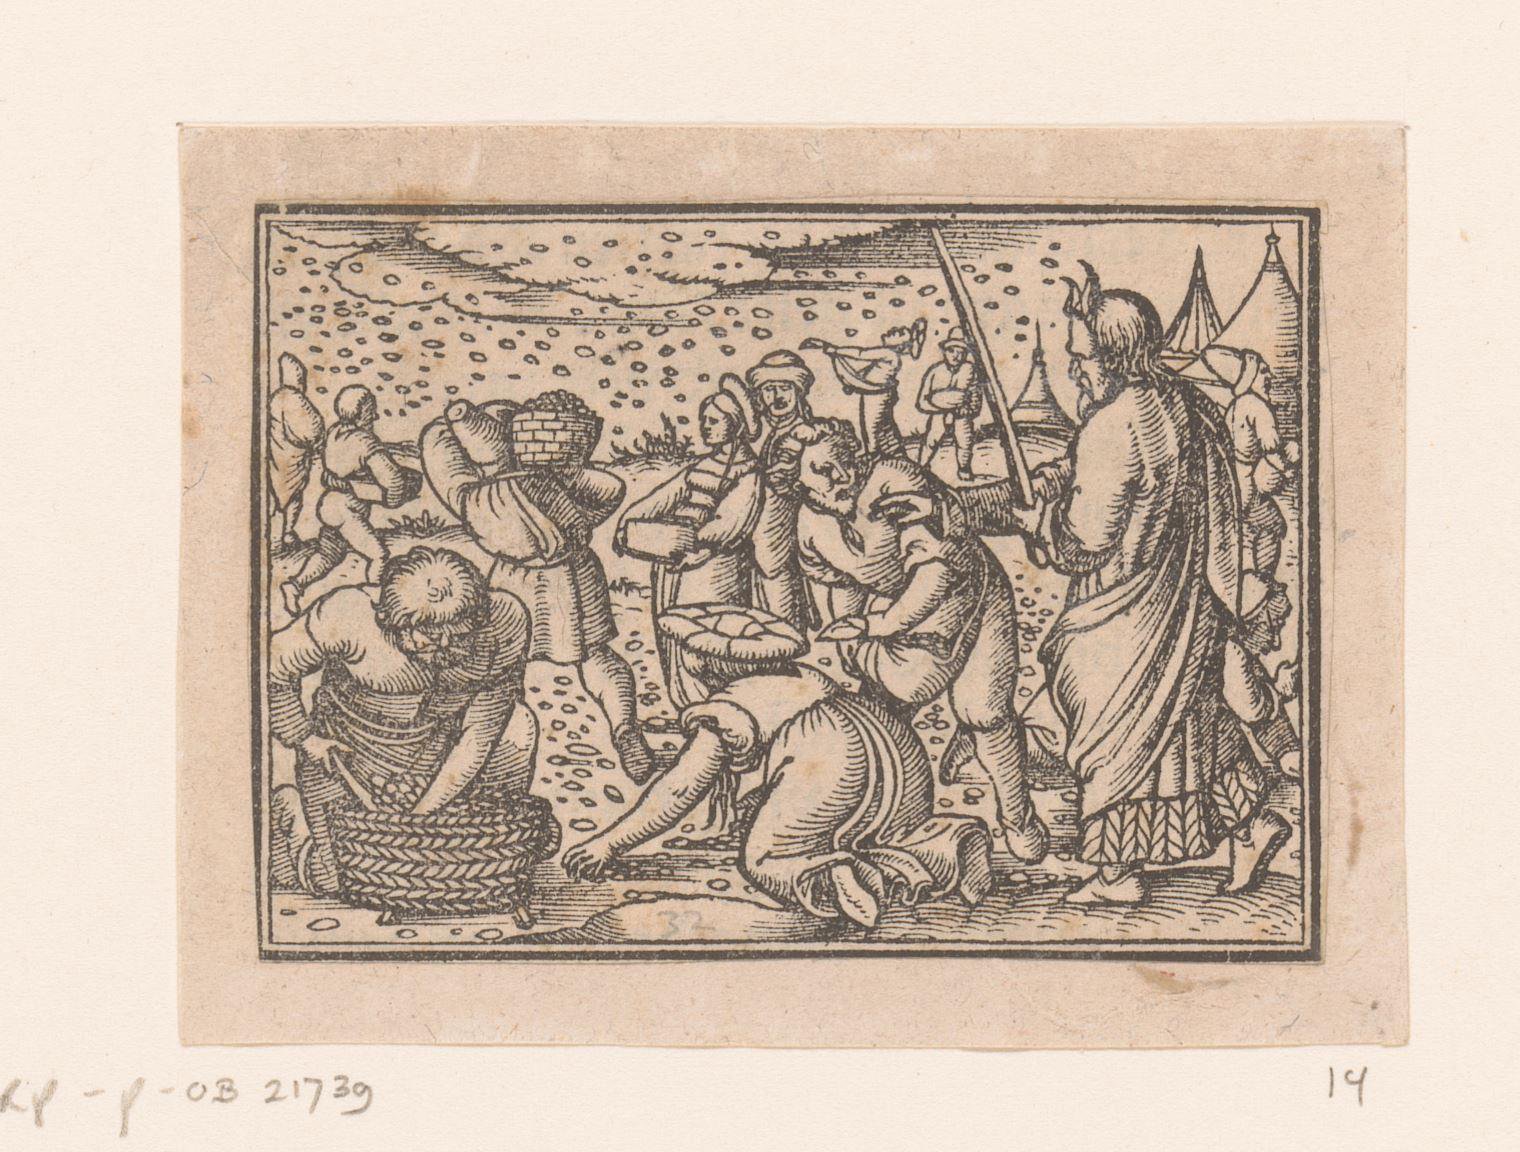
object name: book illustration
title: Mannaregen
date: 1552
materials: paper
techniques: woodcut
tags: the gathering of manna (in baskets and pots)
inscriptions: collector's mark: Lugt 240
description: Gespiegelde kopie van een houtsnede van Hans Holbein de jongere uit 1526. Origineel voor het eerst als boekillustratie gebruikt in: Biblia Utriusque Testamenti iuxta Vulgatam Translationem, Lyon, M. en G. Trechsel (voor Hugo à Porta) 1538. Deze kopie gemaakt voor: Biblia sacra iuxta vulgatam. Parijs: Jean Benoît, 1552.